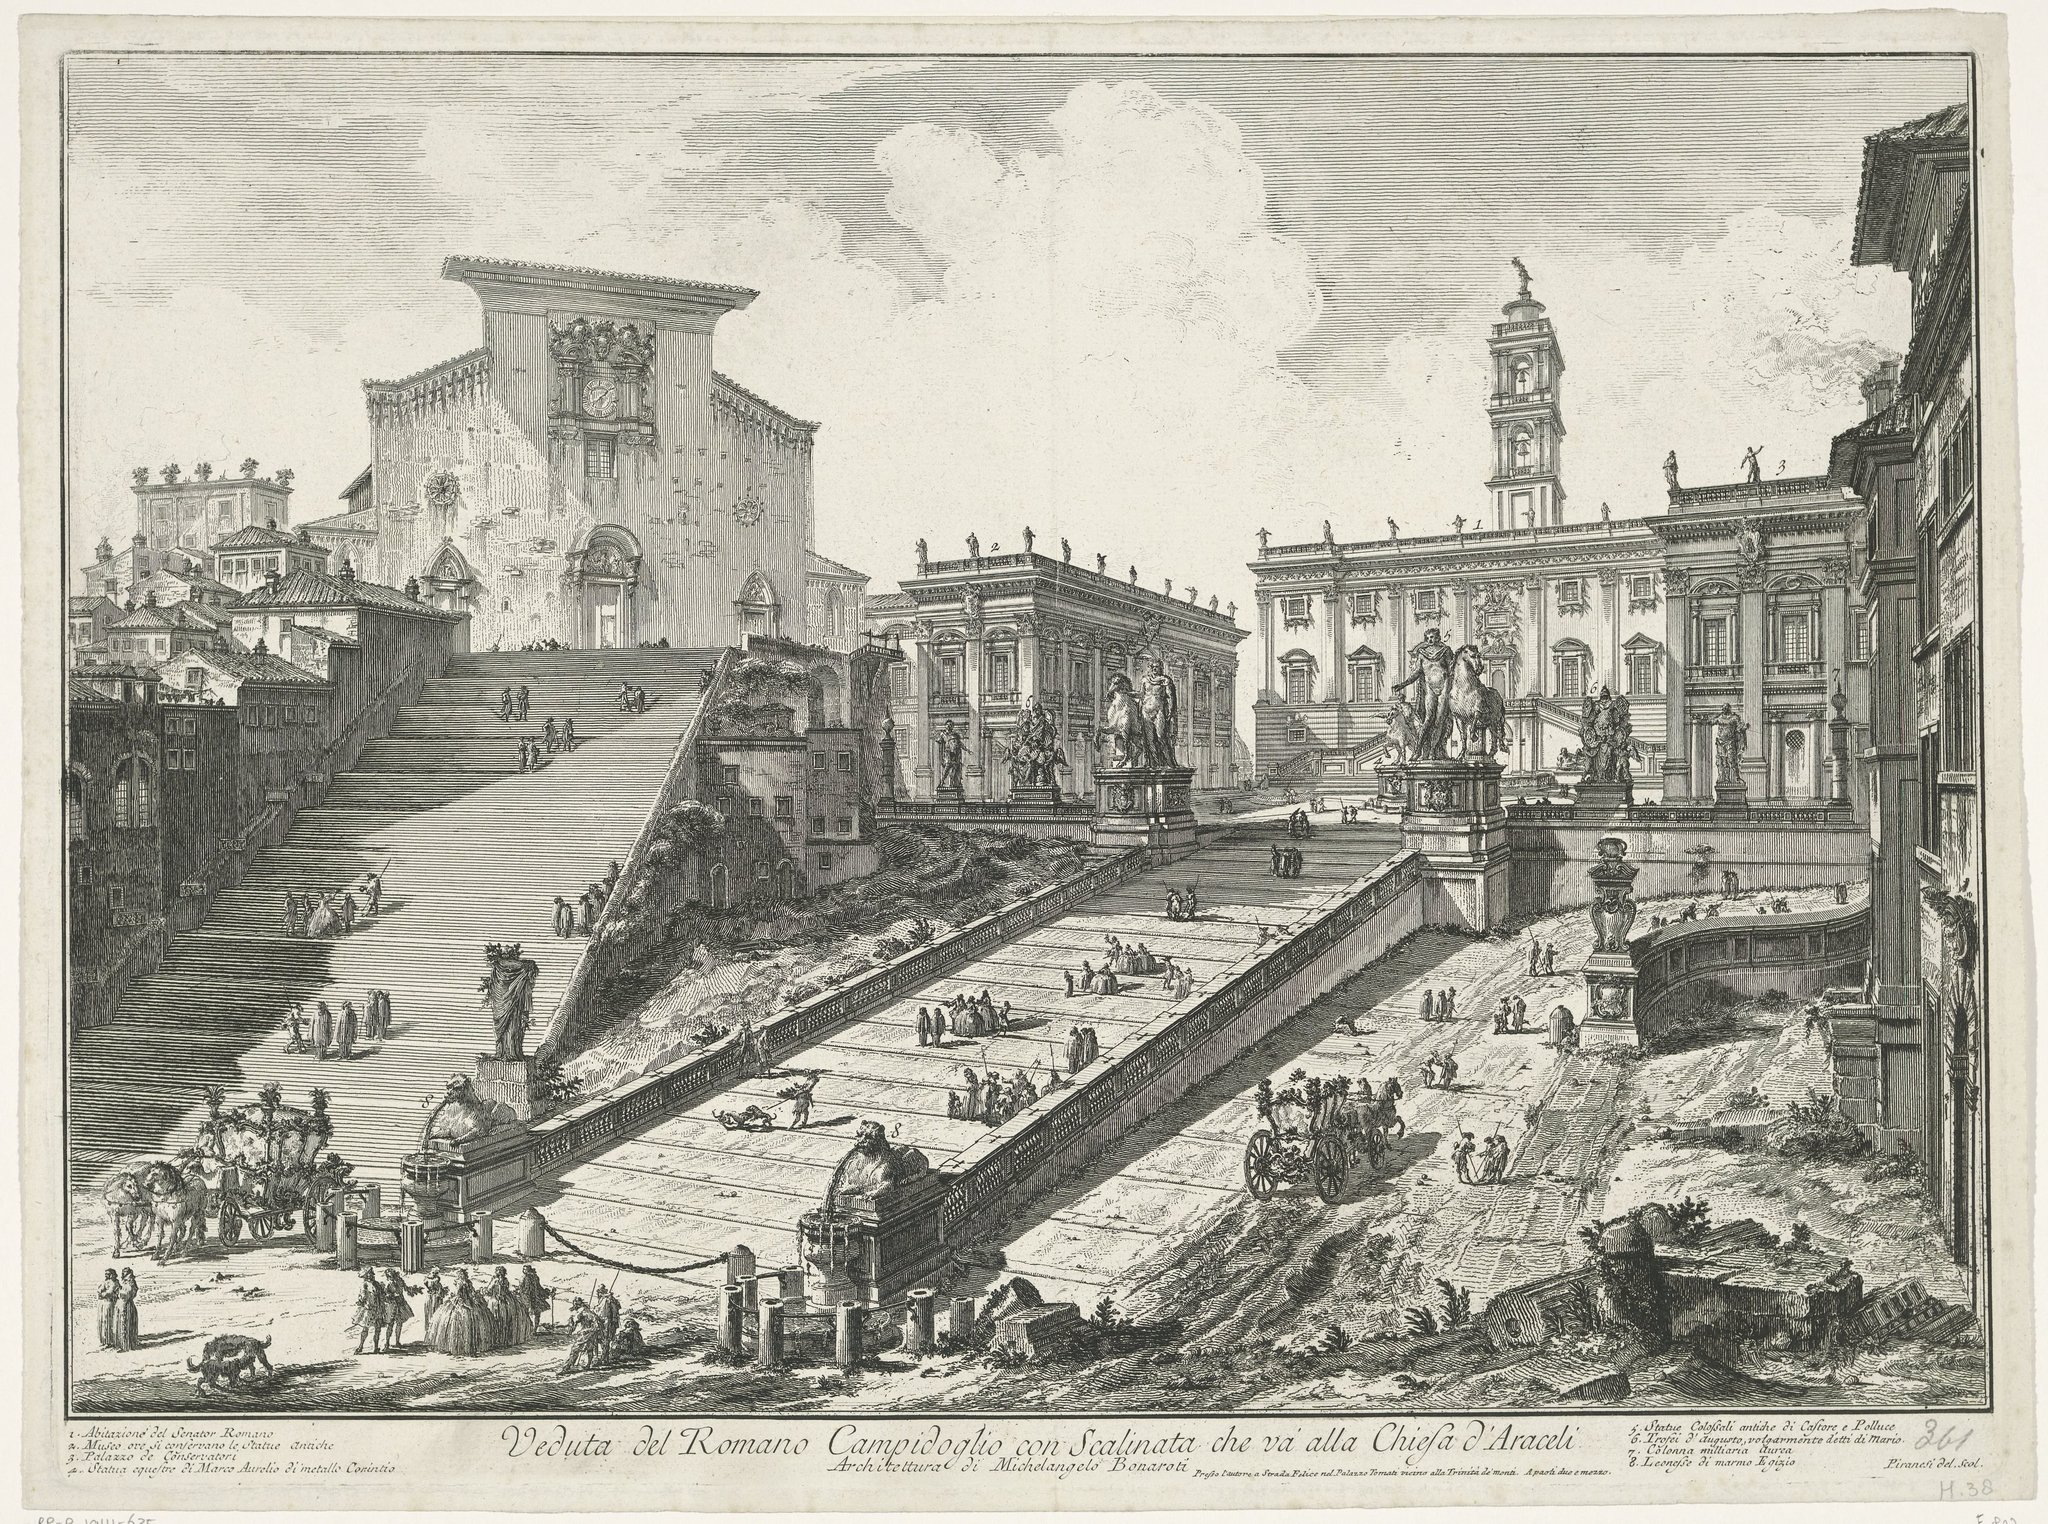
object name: print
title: Veduta del Romano Campidoglio con Scalinata che va alla Chiesa d'Araceli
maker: giovanni battista piranesi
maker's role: designer, draughtsman, print maker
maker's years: 1720-1778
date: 1748-1778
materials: paper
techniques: etching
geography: rome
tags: square, place, circus, etc., city-view, and landscape with man-made constructions, church (exterior), roman catholic church, hôtel, i.e. small palace in city, rome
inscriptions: collector's mark: Lugt 2228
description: Deze prent maakt deel uit van de serie 'Vedute di Roma'. Piranesi werkte aan deze 135 platen tellende serie tussen 1748 en zijn dood in 1778. Francesco Piranesi voegde later nog twee prenten toe aan de reeks van zijn vader.